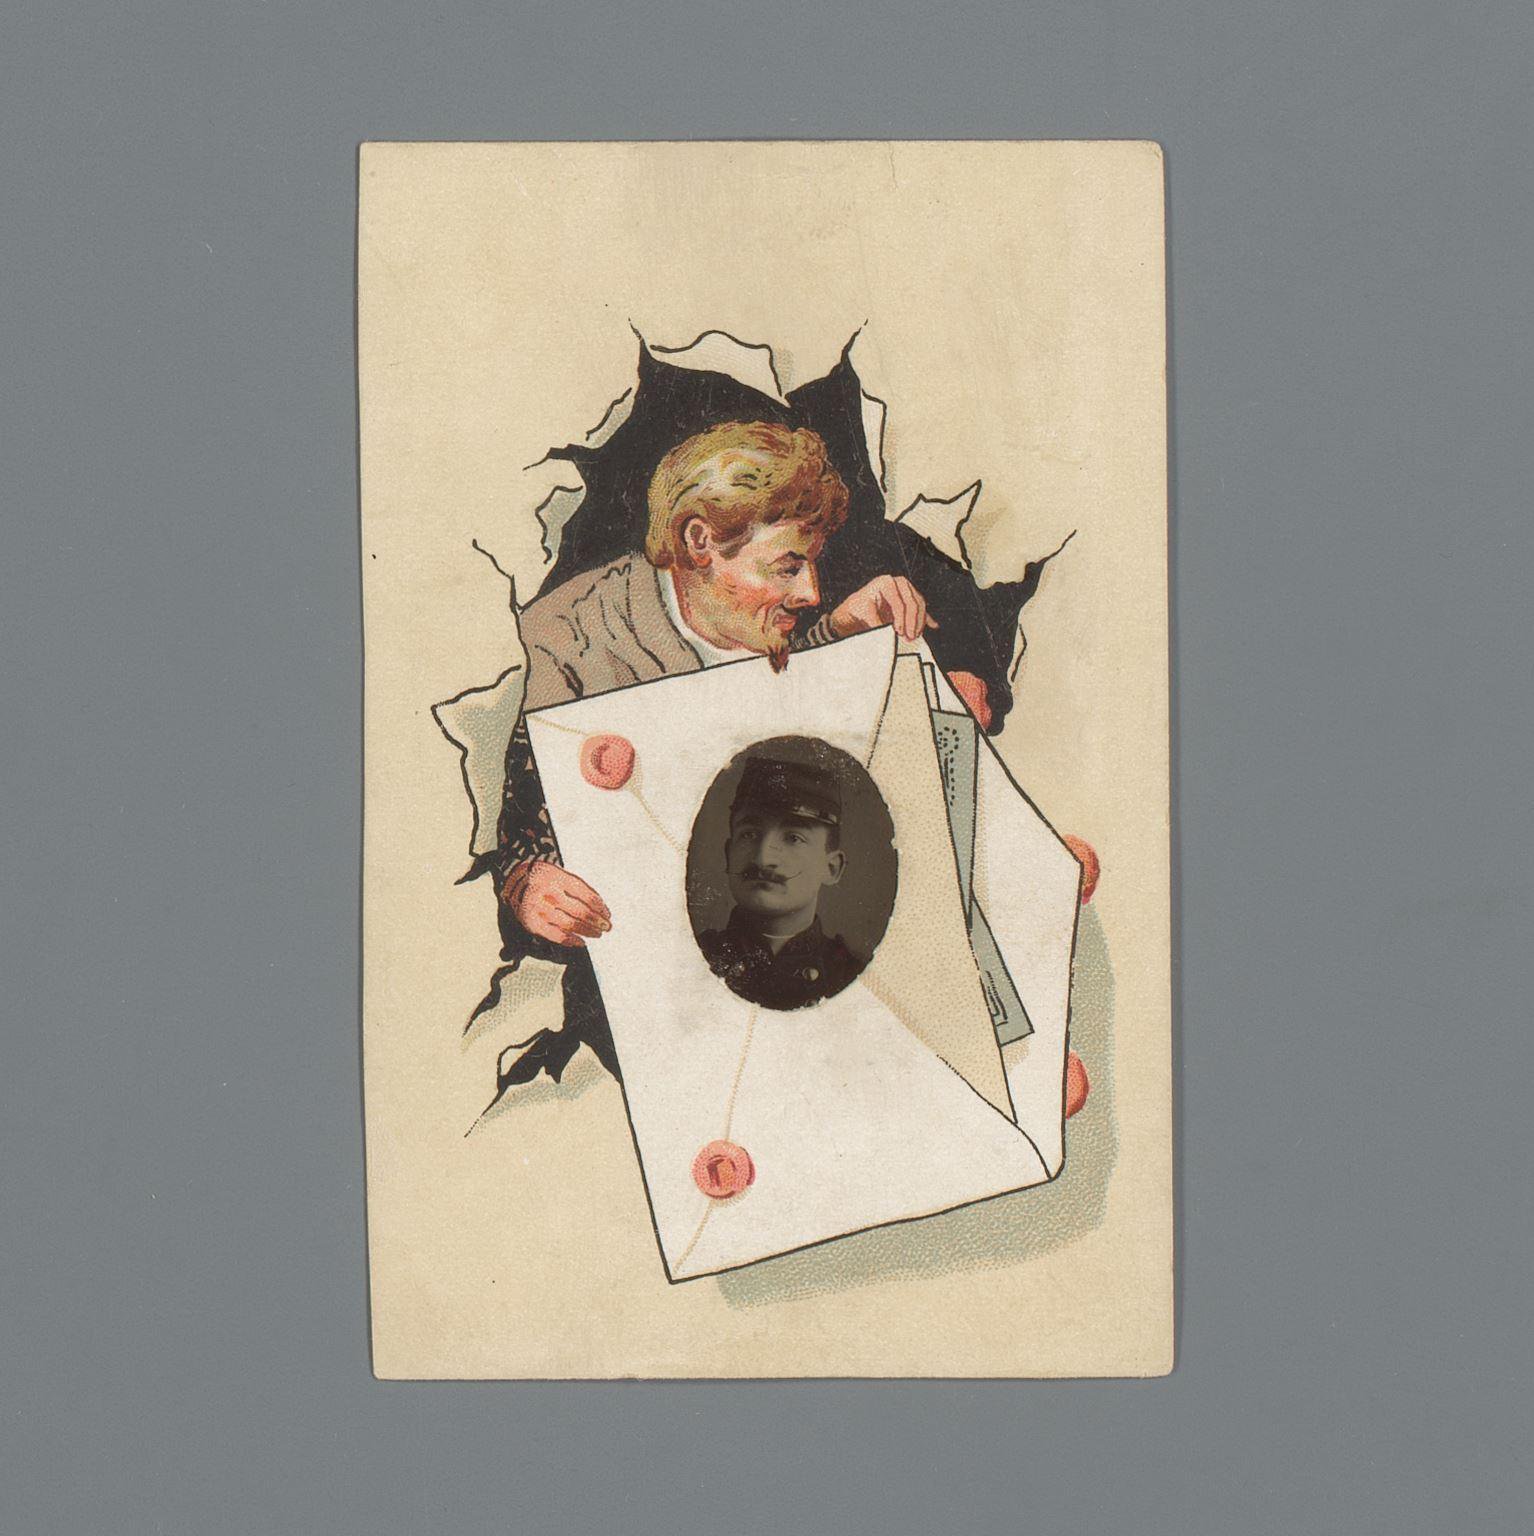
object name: photograph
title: Portret van een onbekende man in uniform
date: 1860-1880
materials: cardboard, iron, paper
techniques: lithograph, ferrotyping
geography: paris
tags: adult man, anonymous historical person portrayed, (military) uniforms, paris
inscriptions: inscription: ‘Photographie/ Cie. Américaine/ 37, Brd. St. Martin/ au 1er./ Paris’